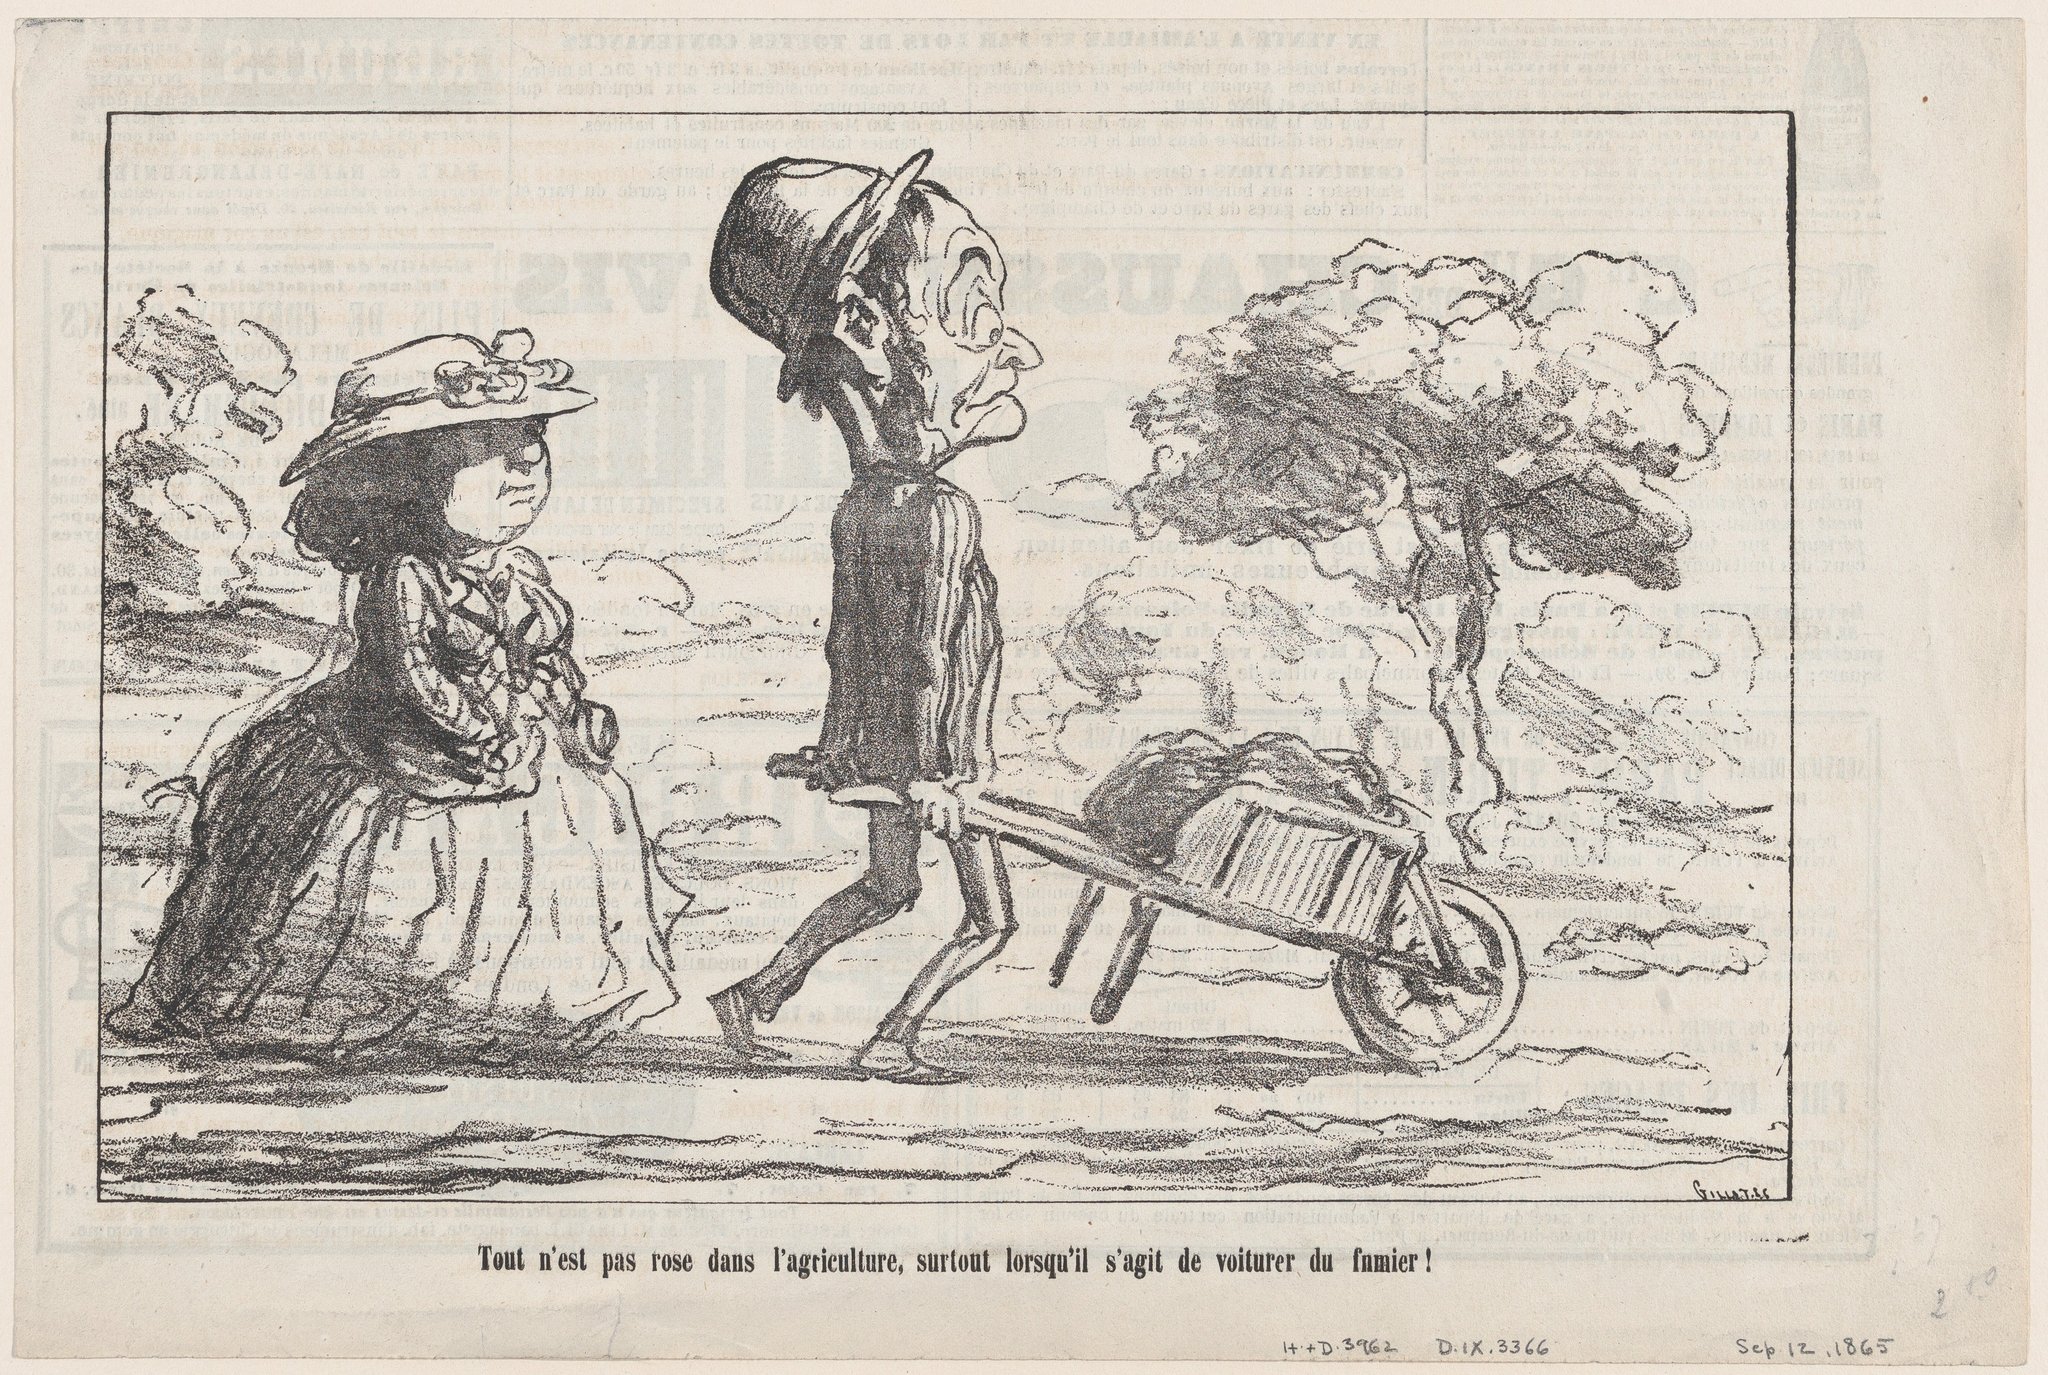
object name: print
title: Not everything in country life smells like roses... especially when having to take care of the manure, from "The joys of country life"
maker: honoré daumier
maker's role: artist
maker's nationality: french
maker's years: 1808-1879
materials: paper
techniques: lithograph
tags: satire,men,women